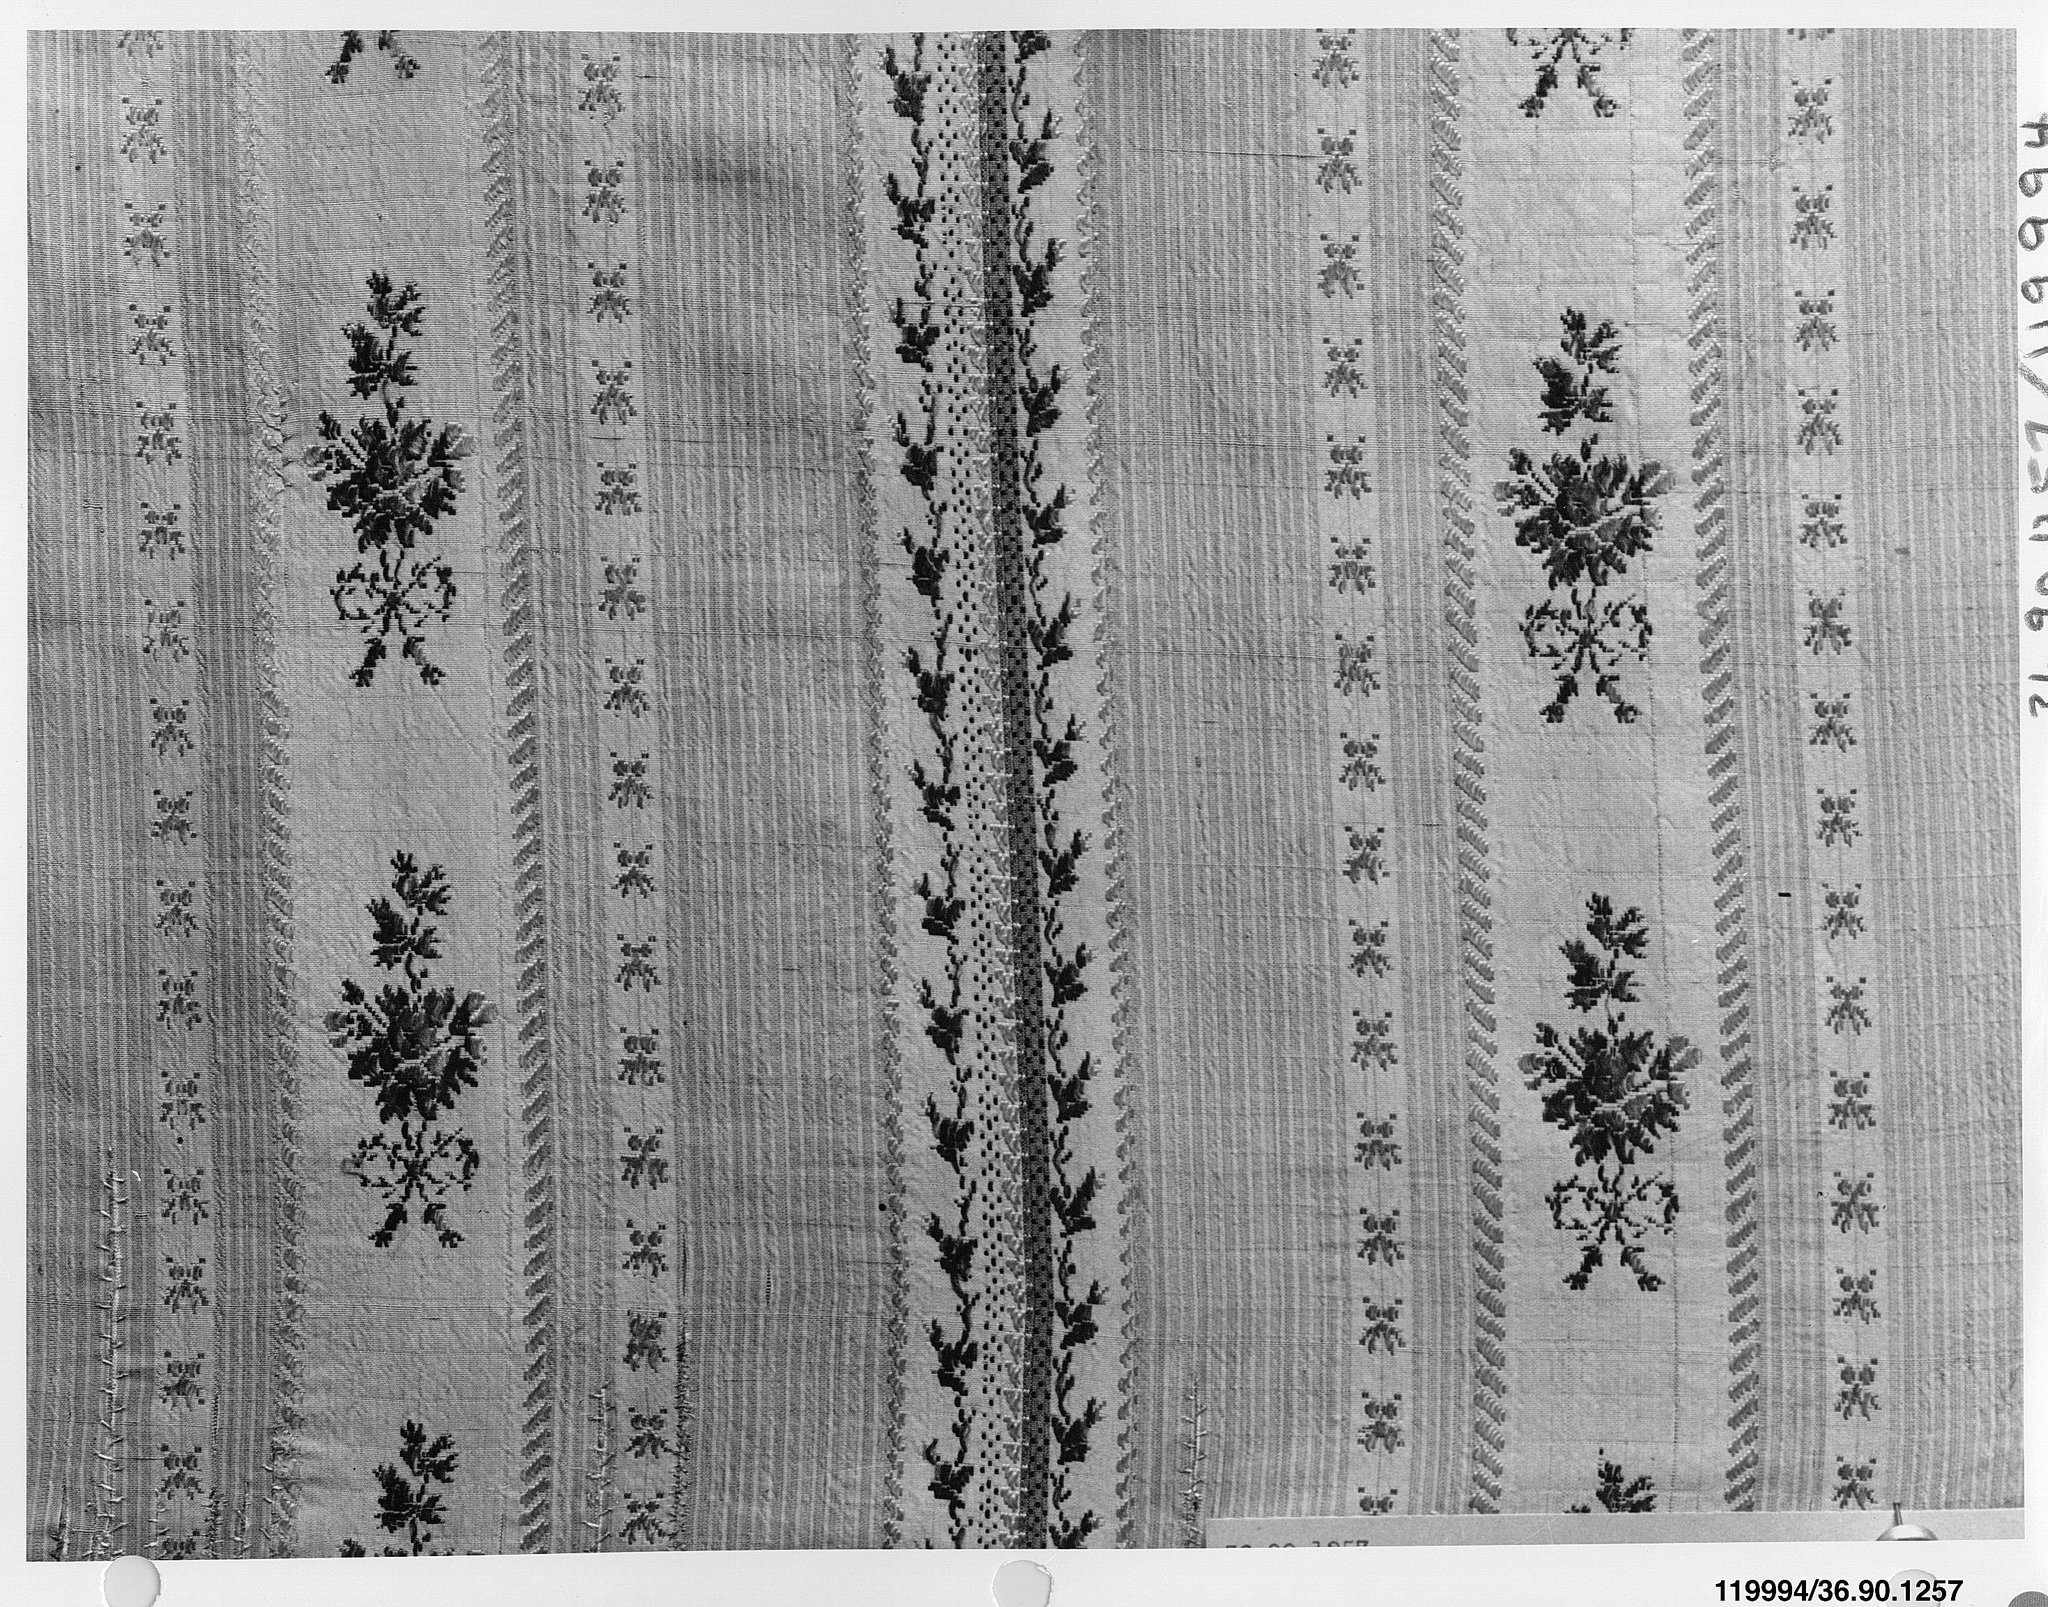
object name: piece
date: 1701-1800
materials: silk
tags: flowers